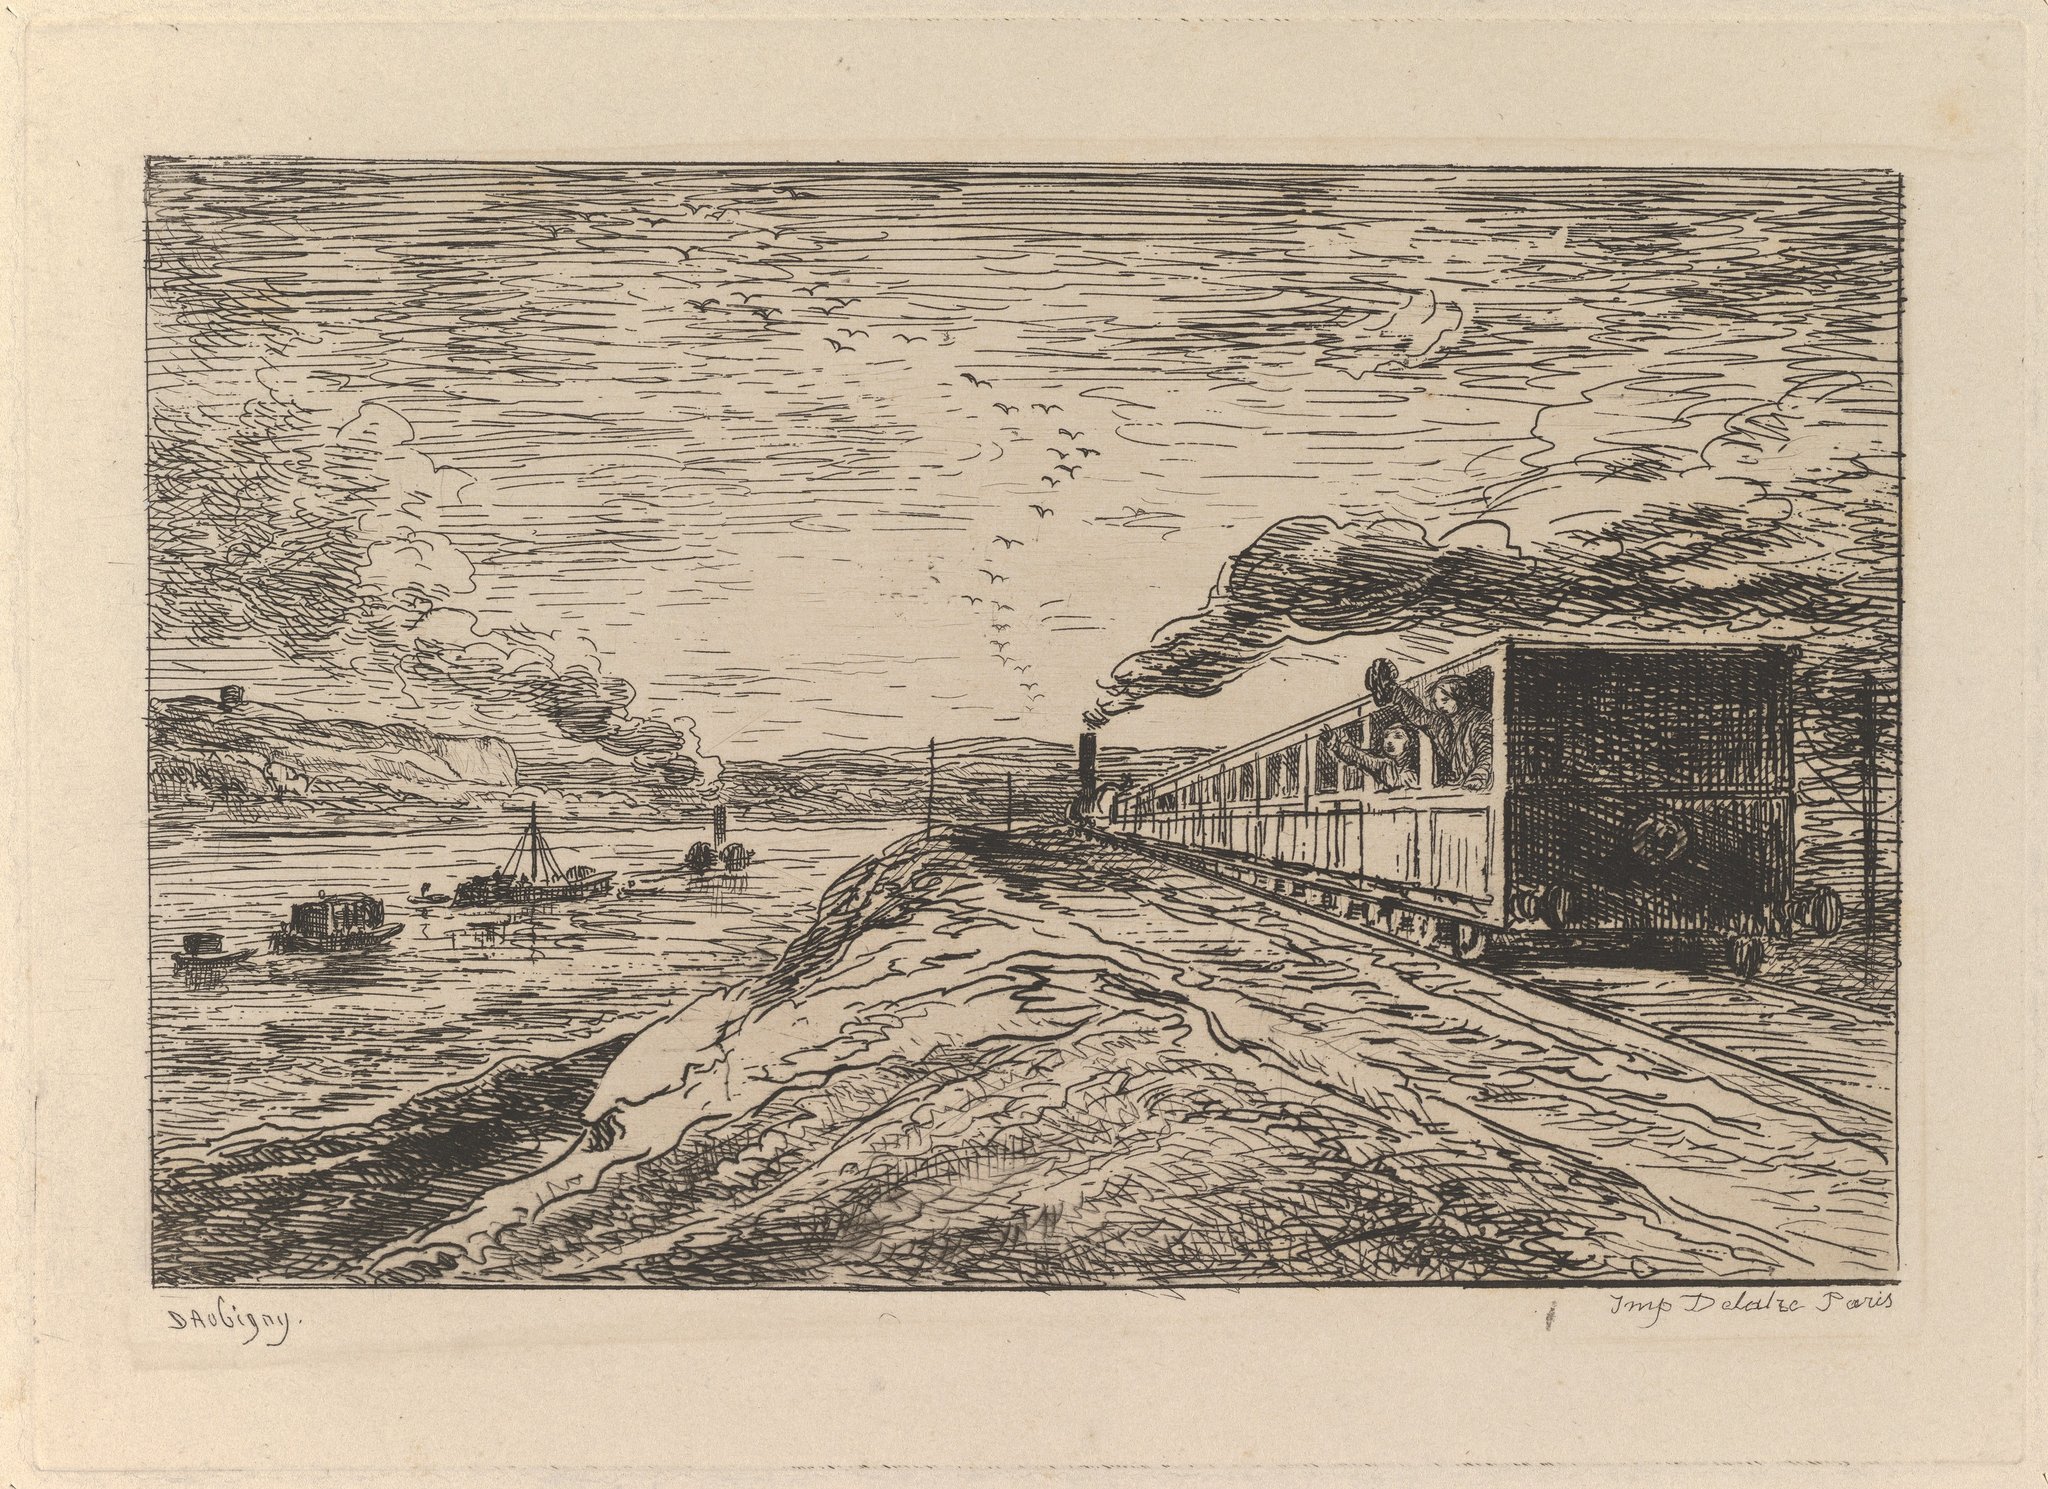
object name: print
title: Le Départ (Le Retour), from Le Voyage en bateau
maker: charles-françois daubigny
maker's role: artist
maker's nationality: french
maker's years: 1817-1878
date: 1861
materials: paper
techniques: etching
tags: railways,boats,trains